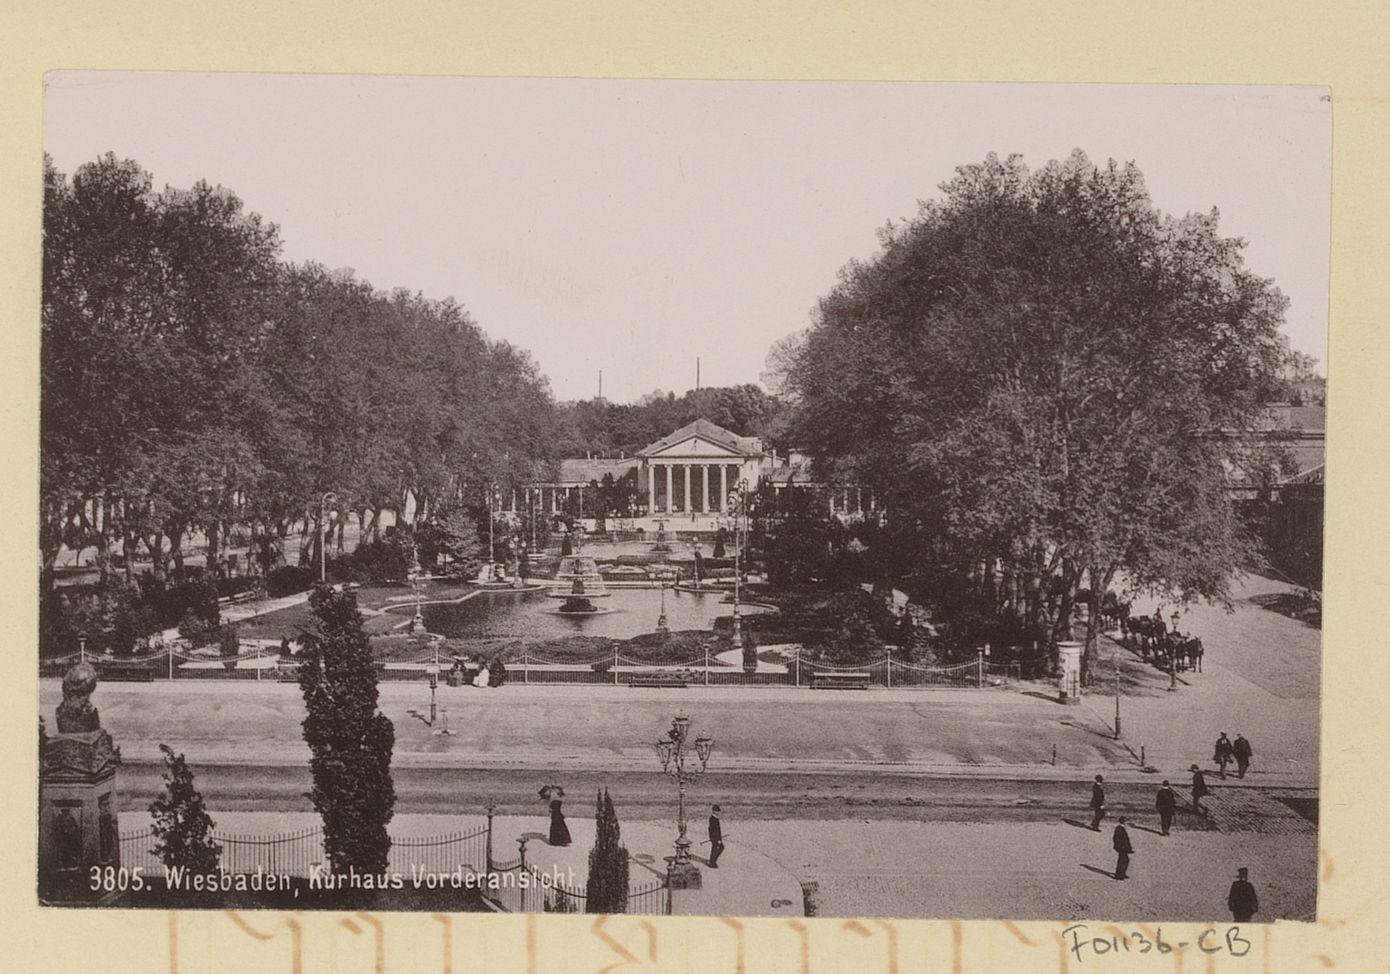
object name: photomechanical print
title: Kurhaus van Wiesbaden met fonteinen en vijvers (vooraanzicht)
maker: Anonymous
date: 1880-1895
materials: paper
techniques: photograph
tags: watering-place, spa, public gardens, park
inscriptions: number: ‘3805’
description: Onderdeel van Fotoalbum met opnames van bezienswaardigheden in België, Duitsland en Noorwegen.